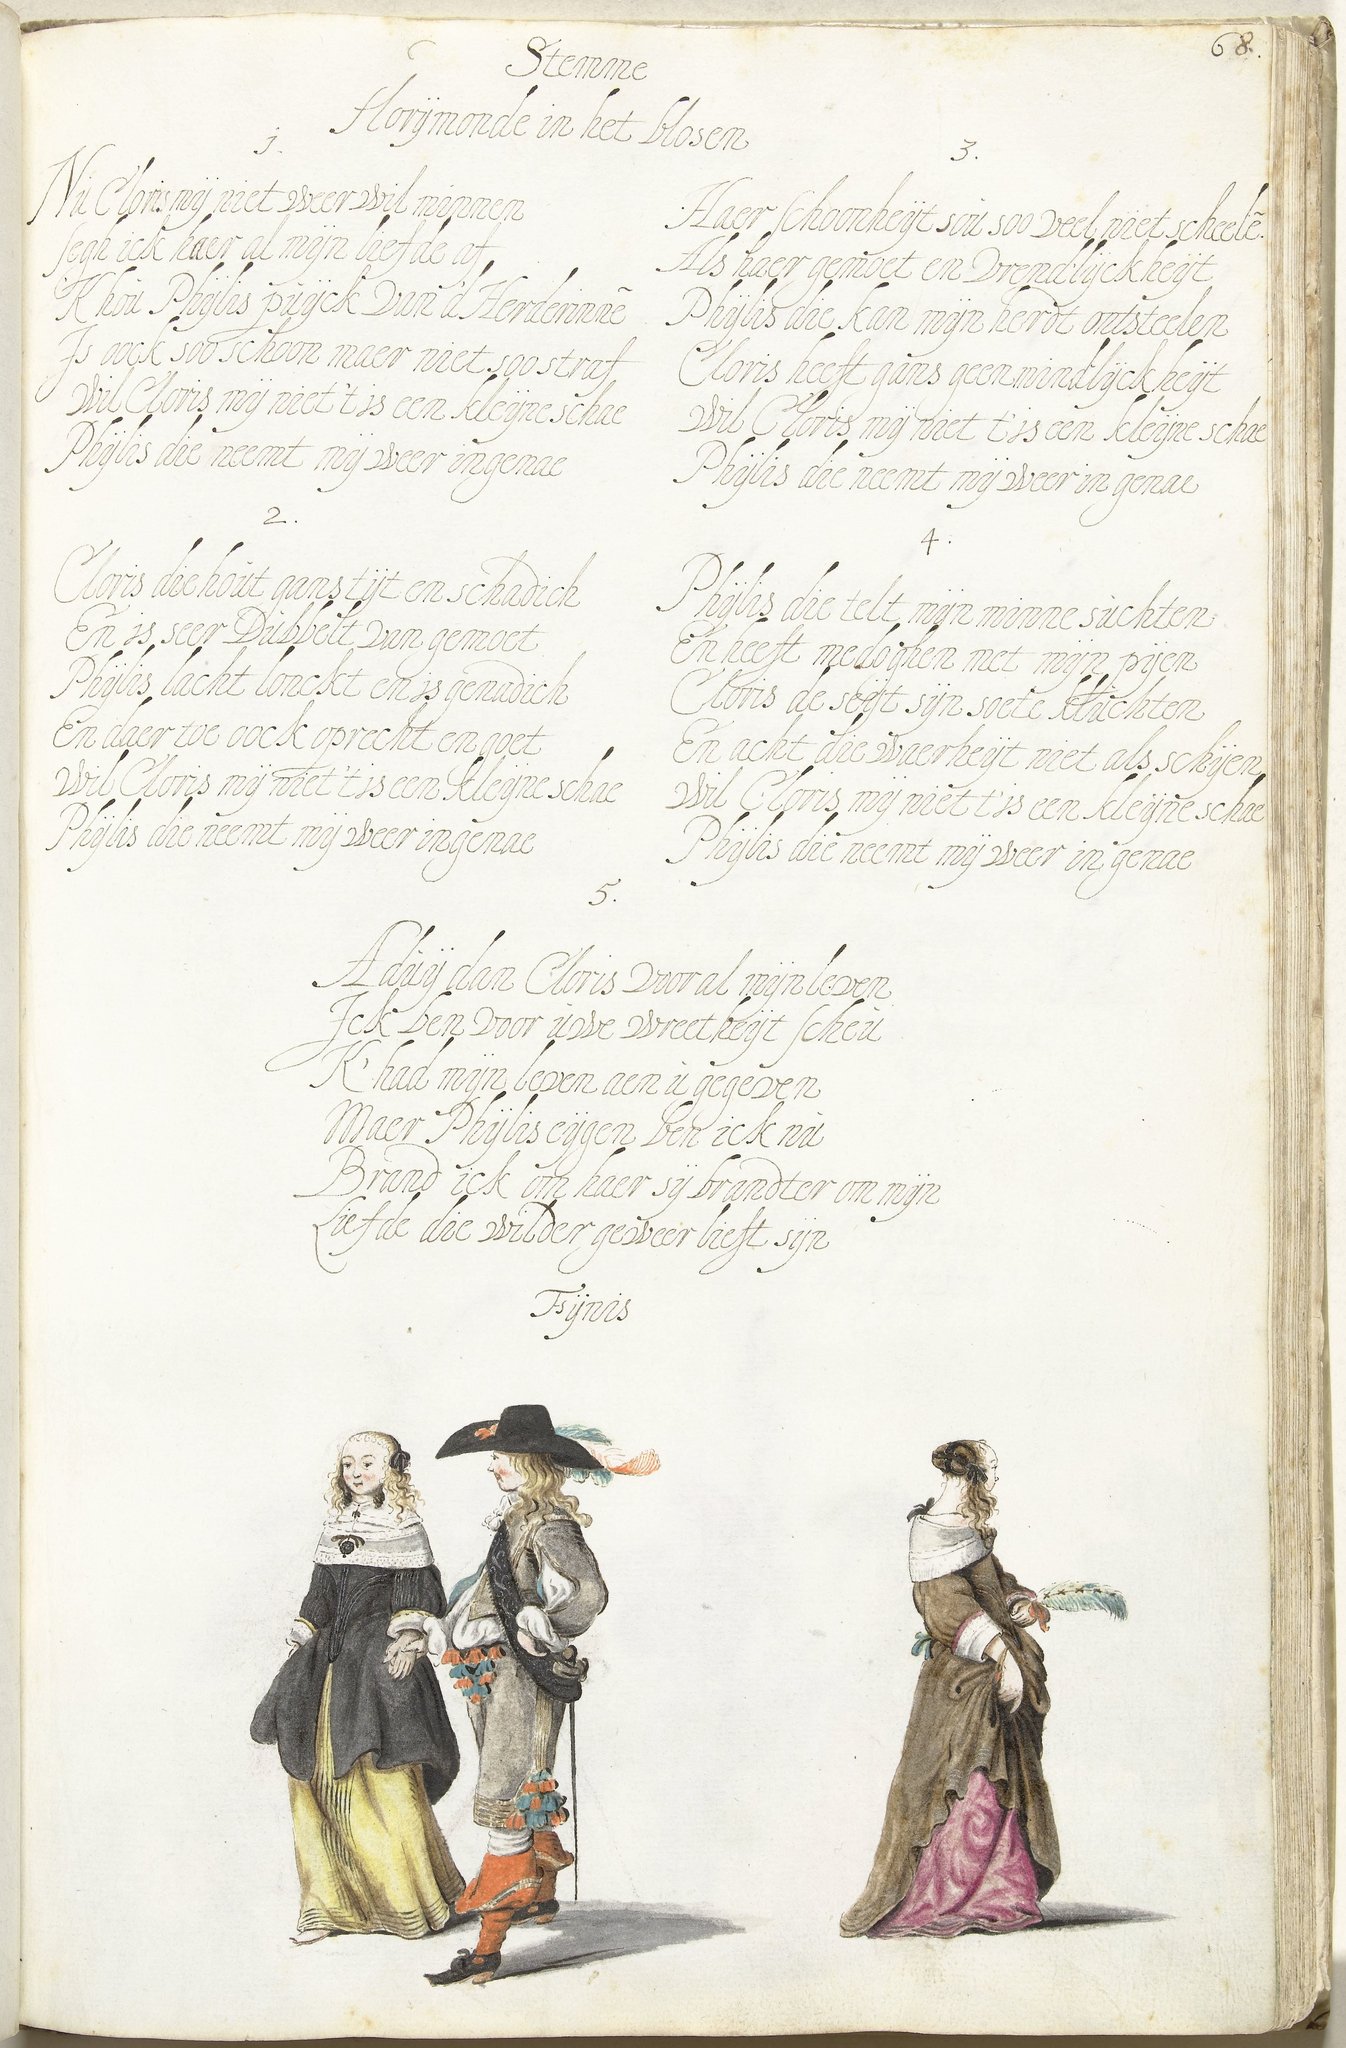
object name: poem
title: Lopende heer en dame en afgewende dame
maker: gesina ter borch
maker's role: draughtsman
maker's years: 1633-1690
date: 1654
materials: ink, paper, watercolor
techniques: brush, calligraphy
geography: zwolle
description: Lopende heer en dame en afgewende dame onder gedicht over een oude en een nieuwe liefde, op de melodie van Florijmonde in het blosen.